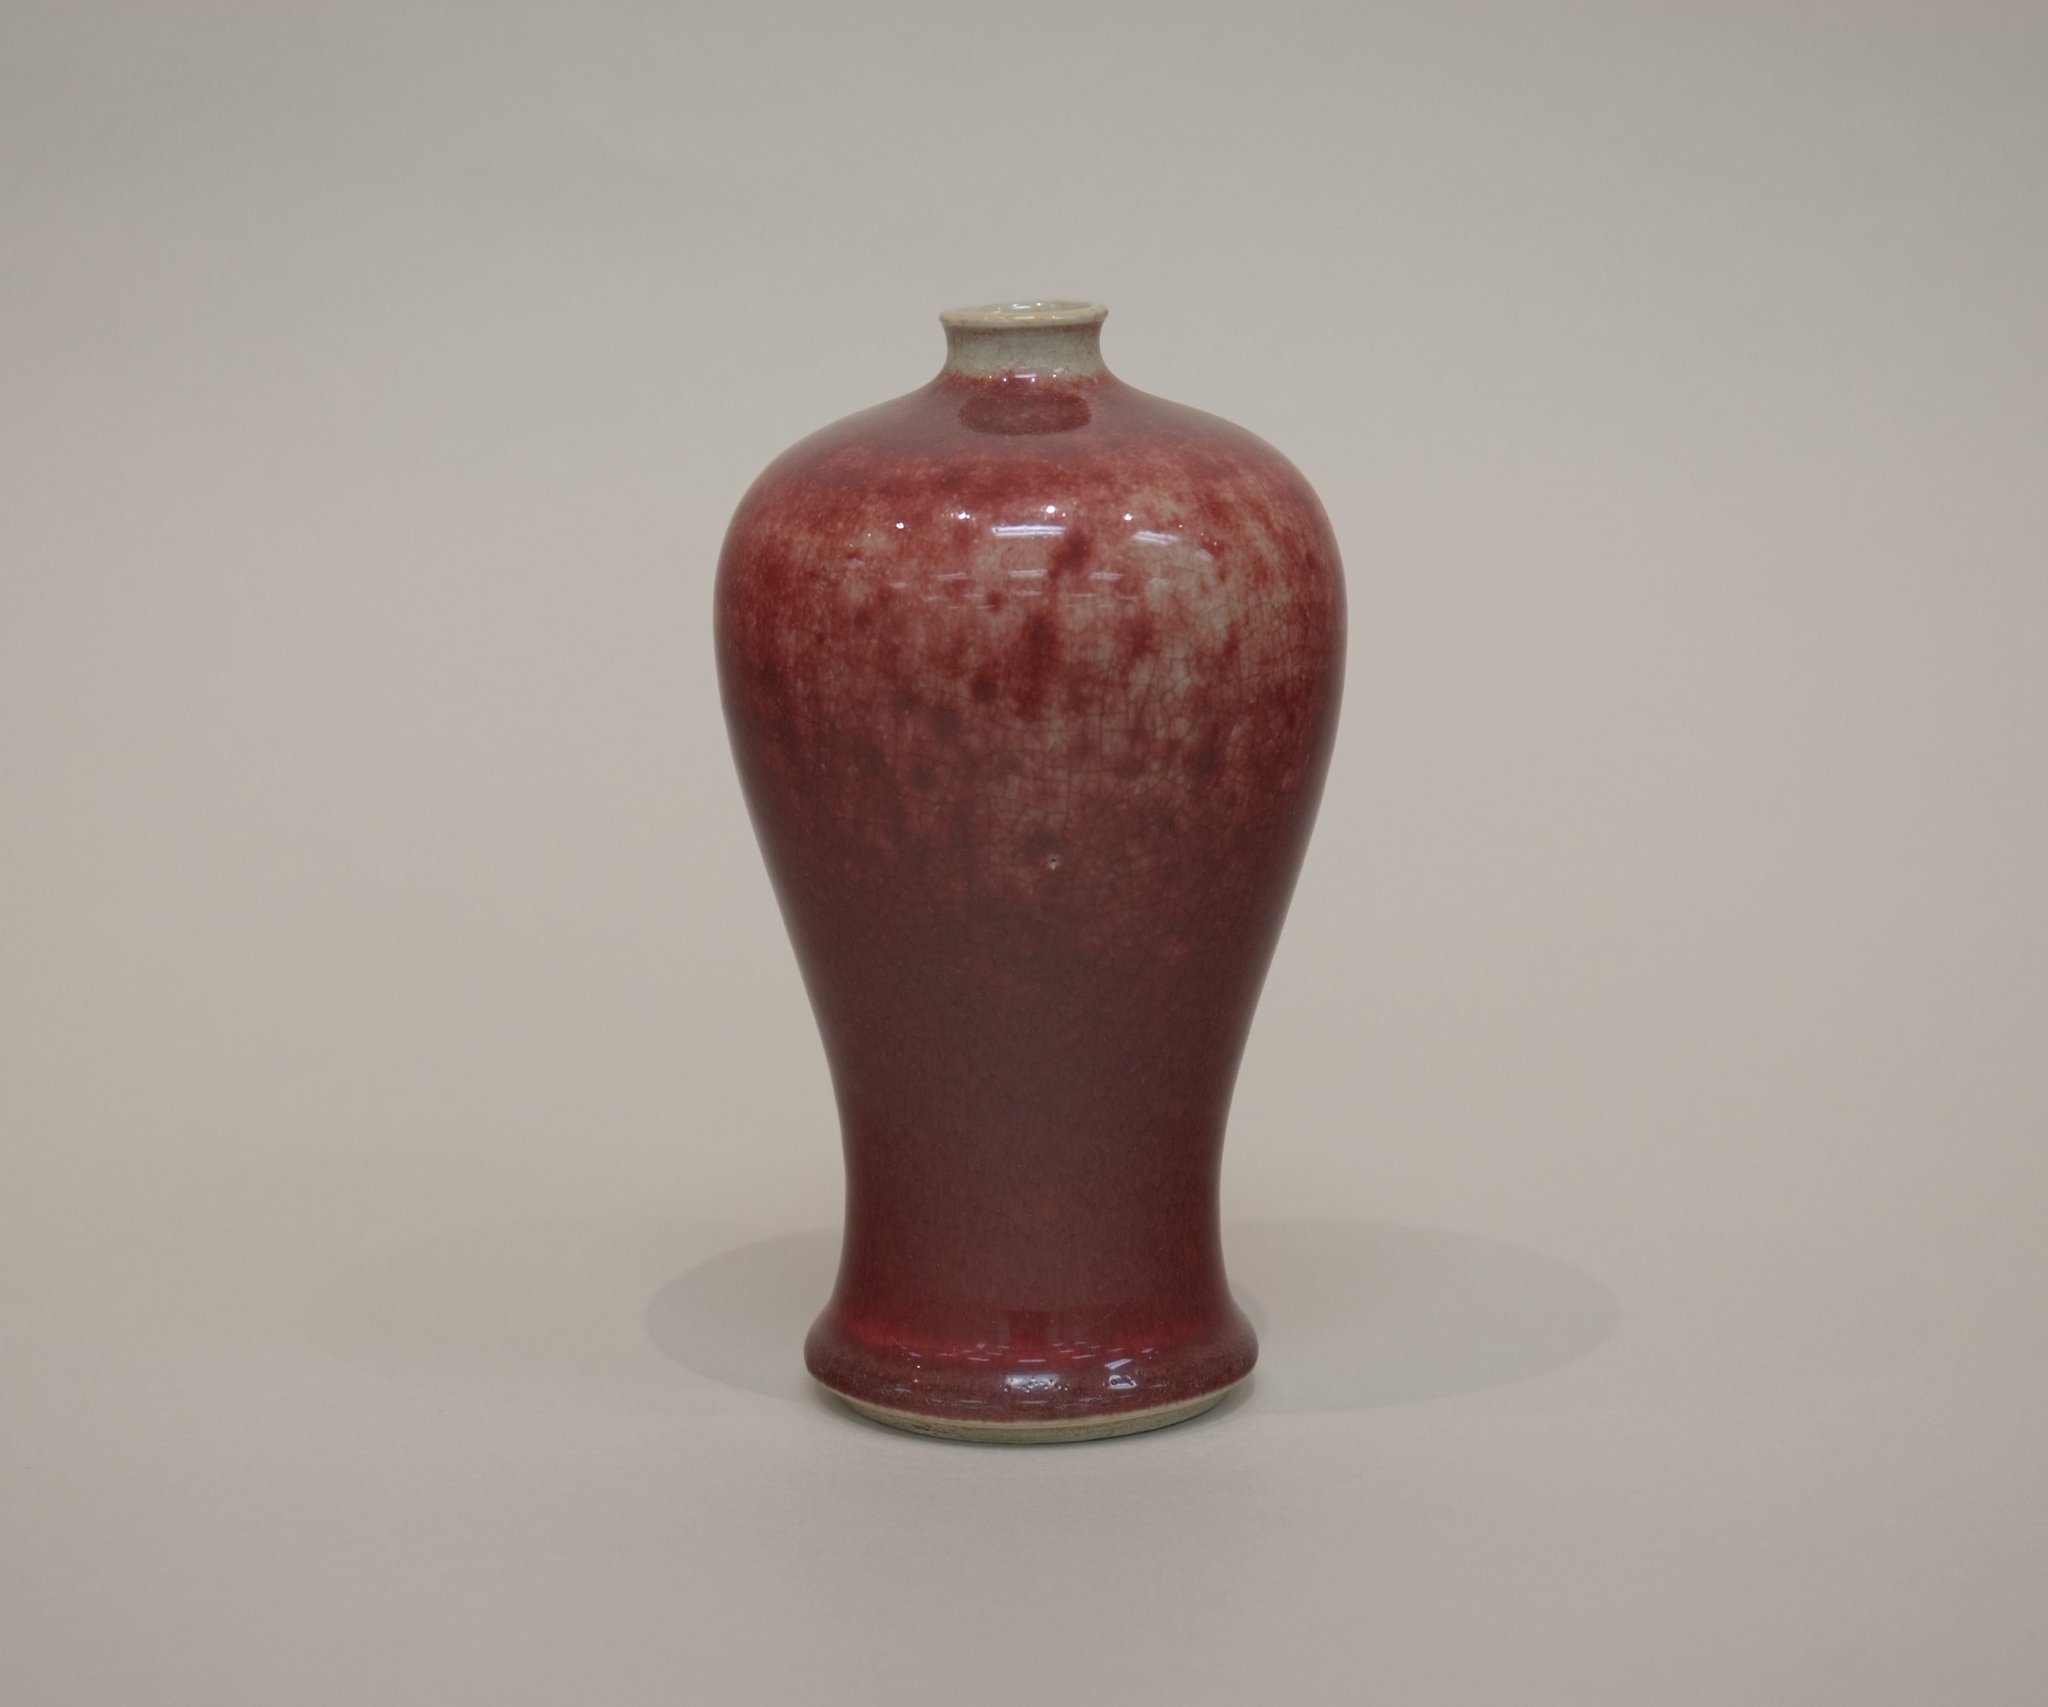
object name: vase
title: Meiping vase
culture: chinese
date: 1667-1733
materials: copper, glaze, porcelain